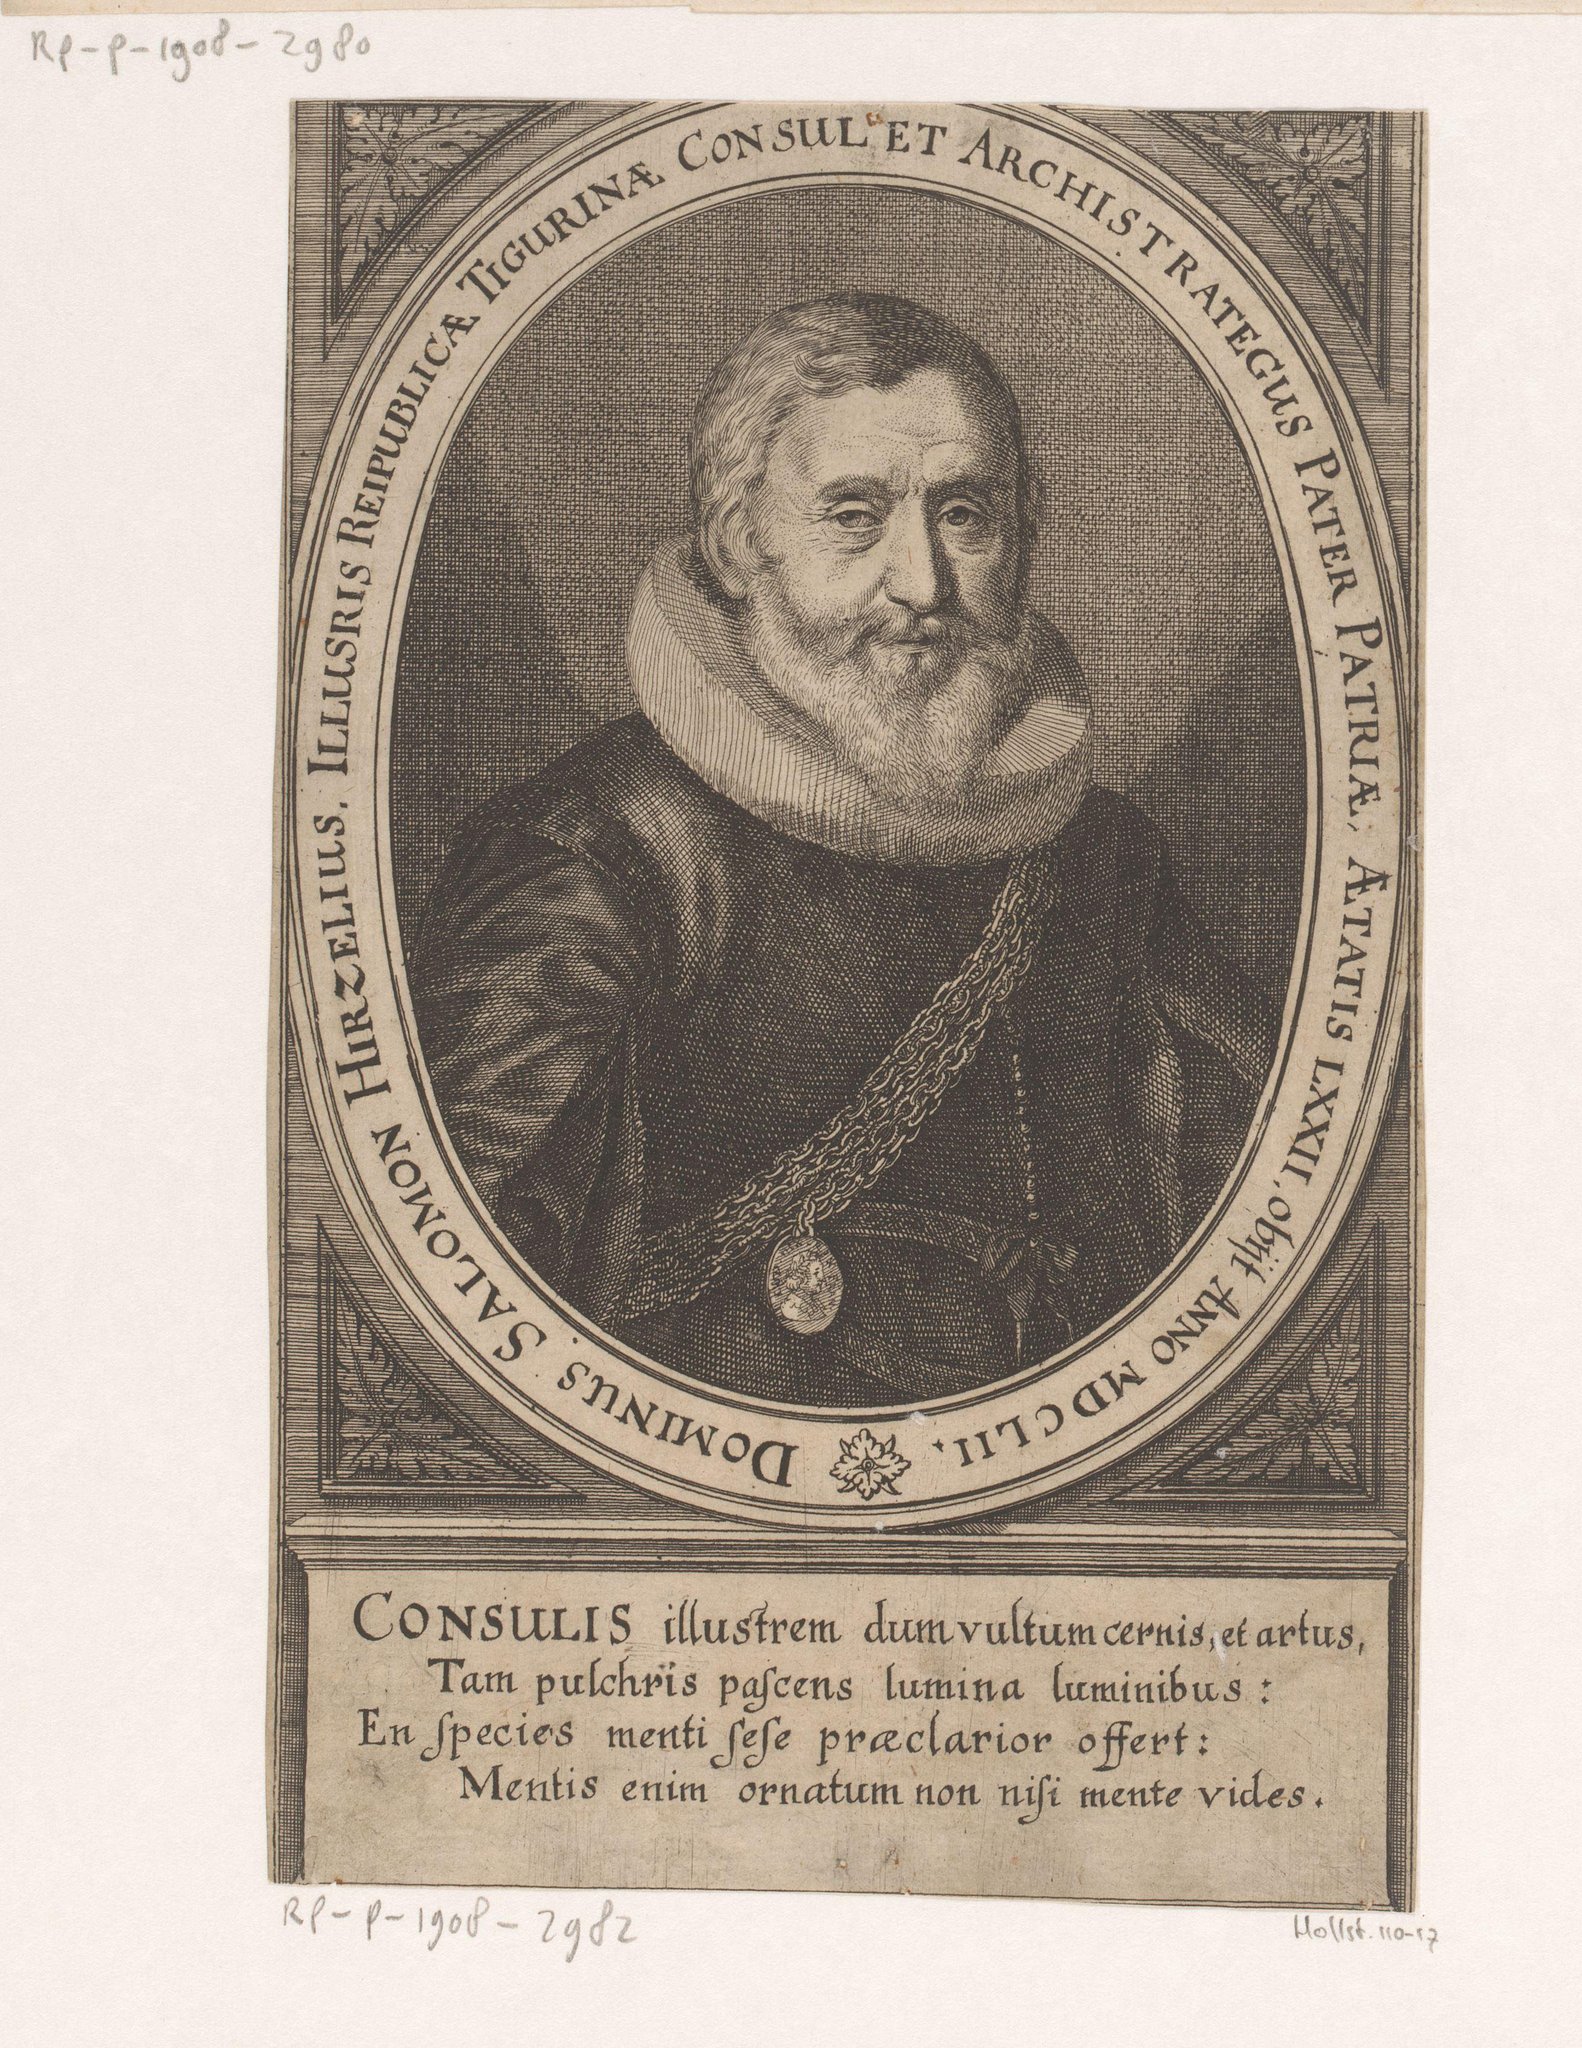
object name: print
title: Portret van Salomon Hirzel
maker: conrad meyer (i)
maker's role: painter, print maker, publisher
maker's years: 1618-1689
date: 1652-1669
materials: paper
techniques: engraving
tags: mayor, mayor, burgomaster, other non-personal regalia, e.g. mayor chain, historical persons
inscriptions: collector's mark: Lugt 2228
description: Onderdeel van een serie van 67(?) portretten van burgemeesters van Zürich. Zie Hollstein German 110, 1-26.